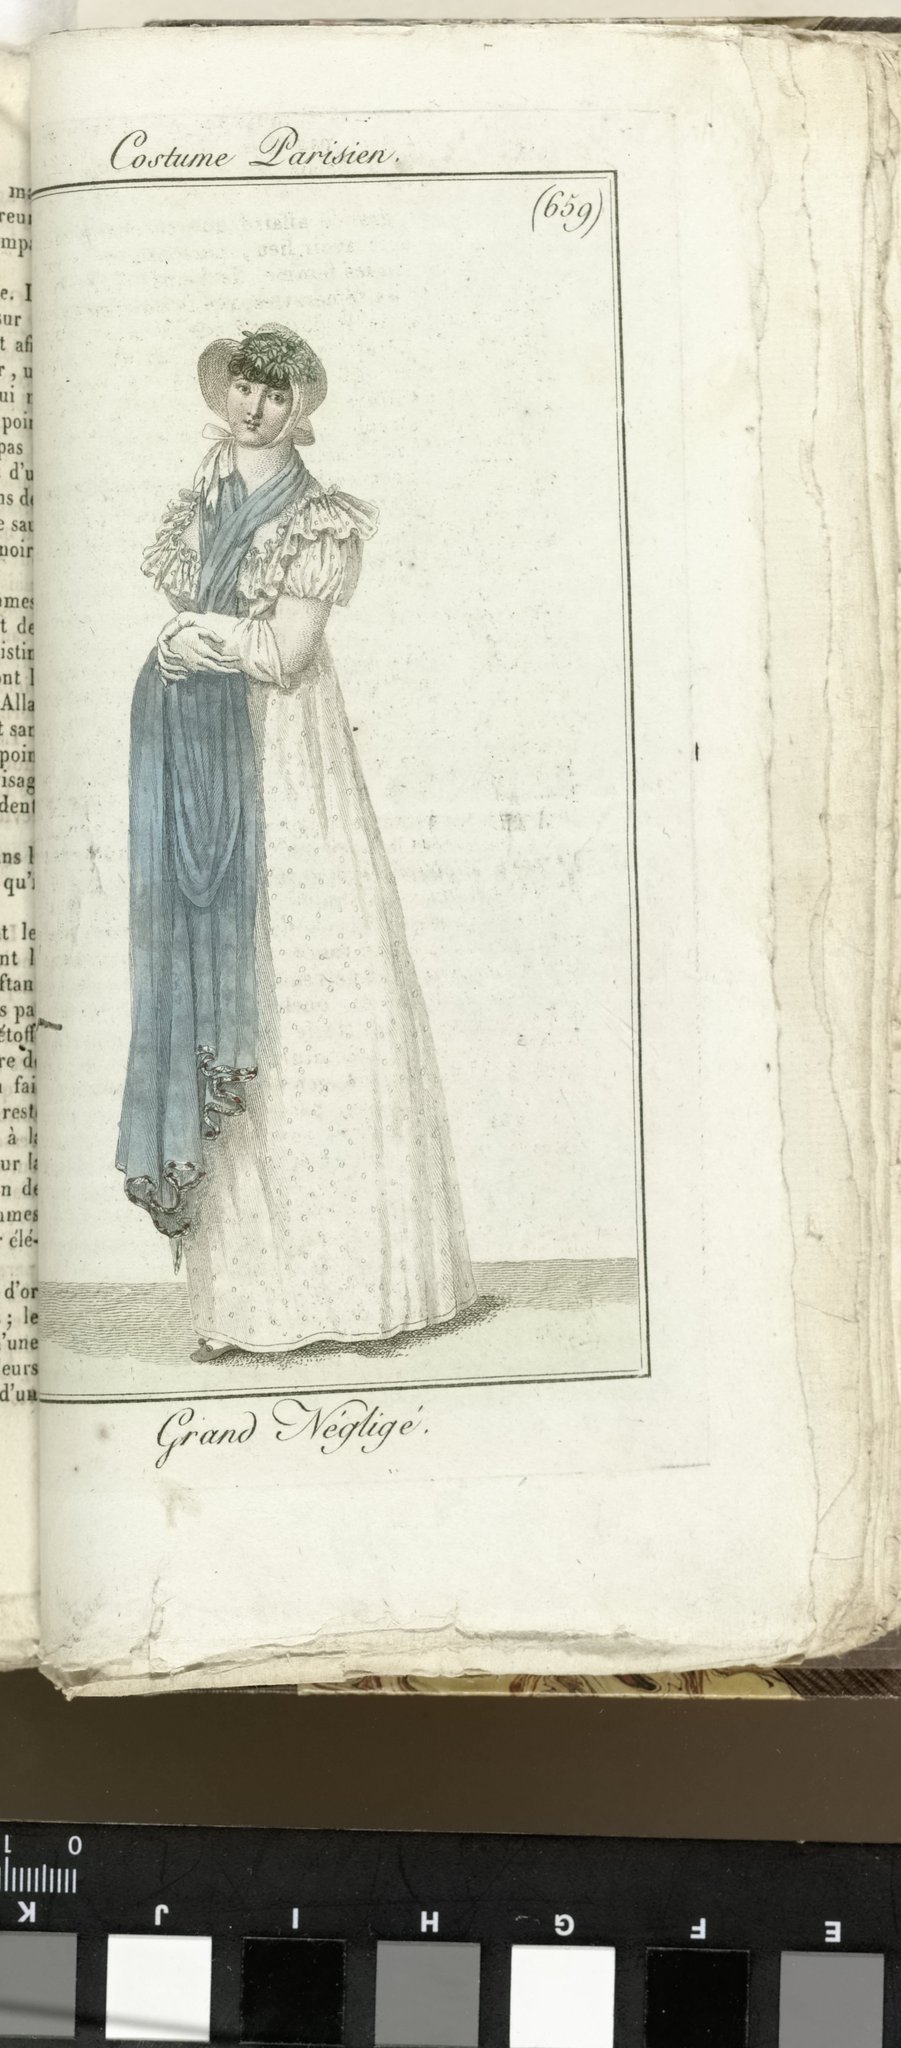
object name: fashion print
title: Journal des Dames et des Modes, Costume Parisien, 1805, An 13 (659) Grand Négligé.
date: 1805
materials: paper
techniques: engraving, hand coloring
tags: head-gear (capote) (+ women's clothes), gloves, mittens (long gloves) (+ women's clothes), dress, gown: morning dress (+ women's clothes), neck-gear ~ clothing (shawl) (+ women's clothes), fashion plates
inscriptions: title: ‘Grand Négligé.’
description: Jonge vrouw in 'grand négligé": witte japon met laag decolleté met rouches. Blauwe lange sjaal om de hals, van voren vastgehouden. Op het hoofd een capote met een klein toefje bloemen. De prent maakt deel uit van het modetijdschrift Journal des Dames et des Modes, uitgegeven door Pierre de la Mésangère, Parijs, 1797-1839.